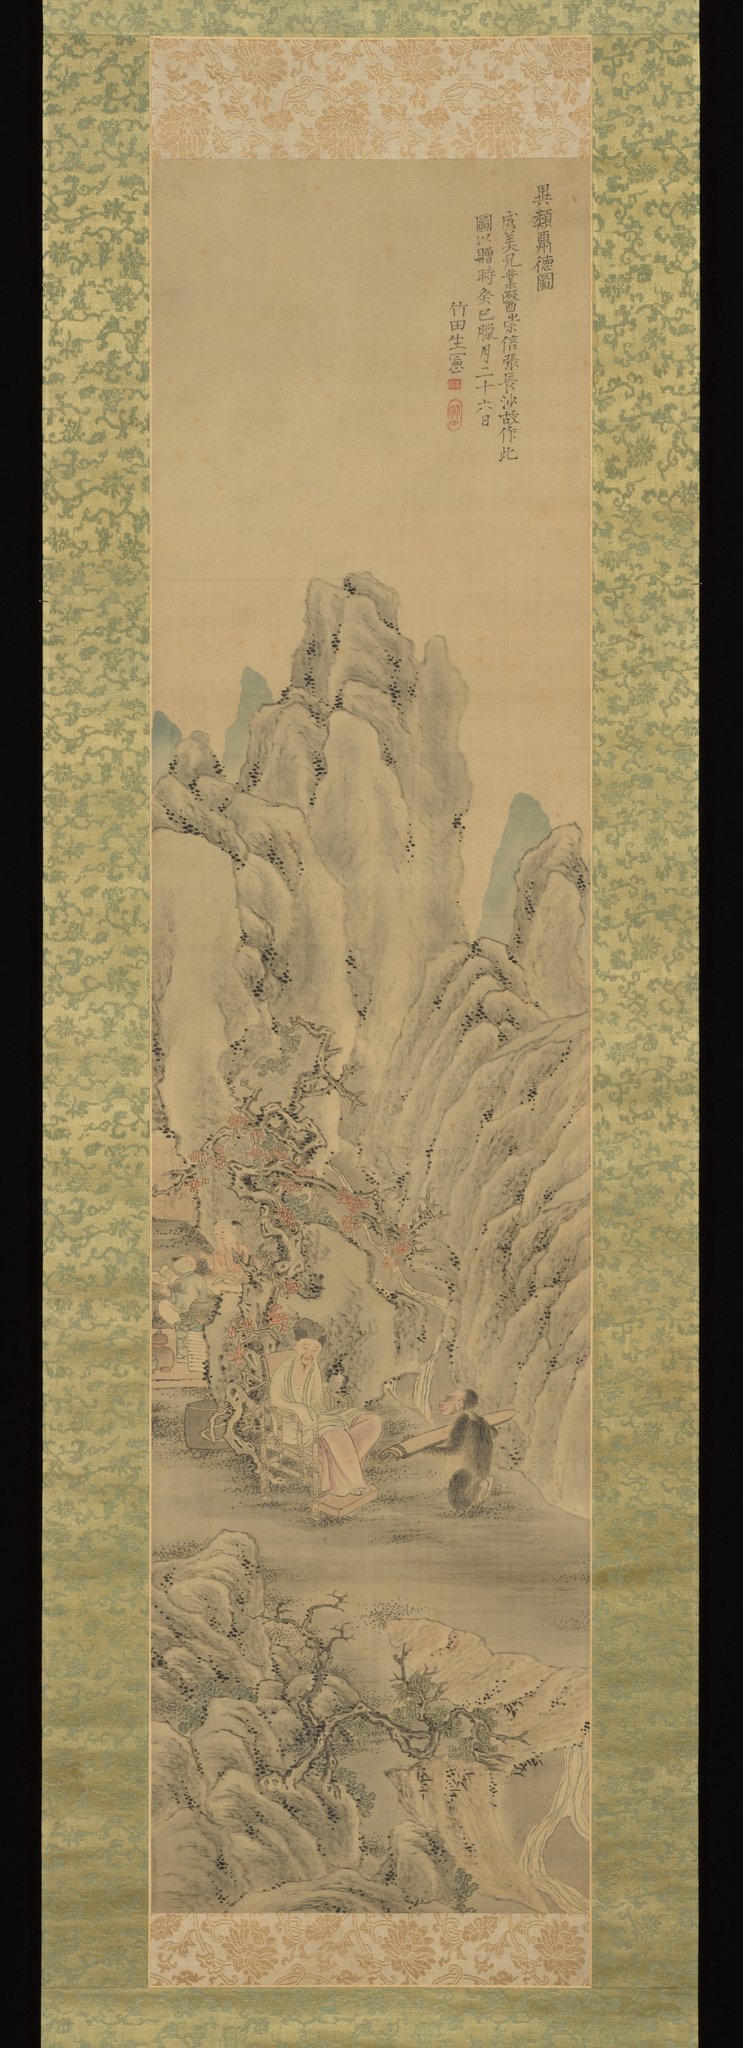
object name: hanging scroll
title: Monkey Offering a Qin to Scholar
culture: japanese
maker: tanomura chikuden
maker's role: artist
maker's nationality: japanese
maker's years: 1777-1835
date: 1833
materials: ink, silk